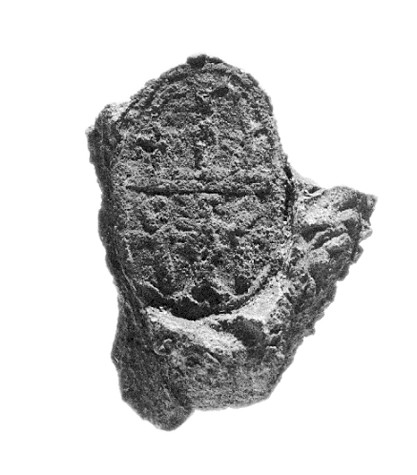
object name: sealing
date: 1981-1640 BCE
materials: mud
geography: egypt